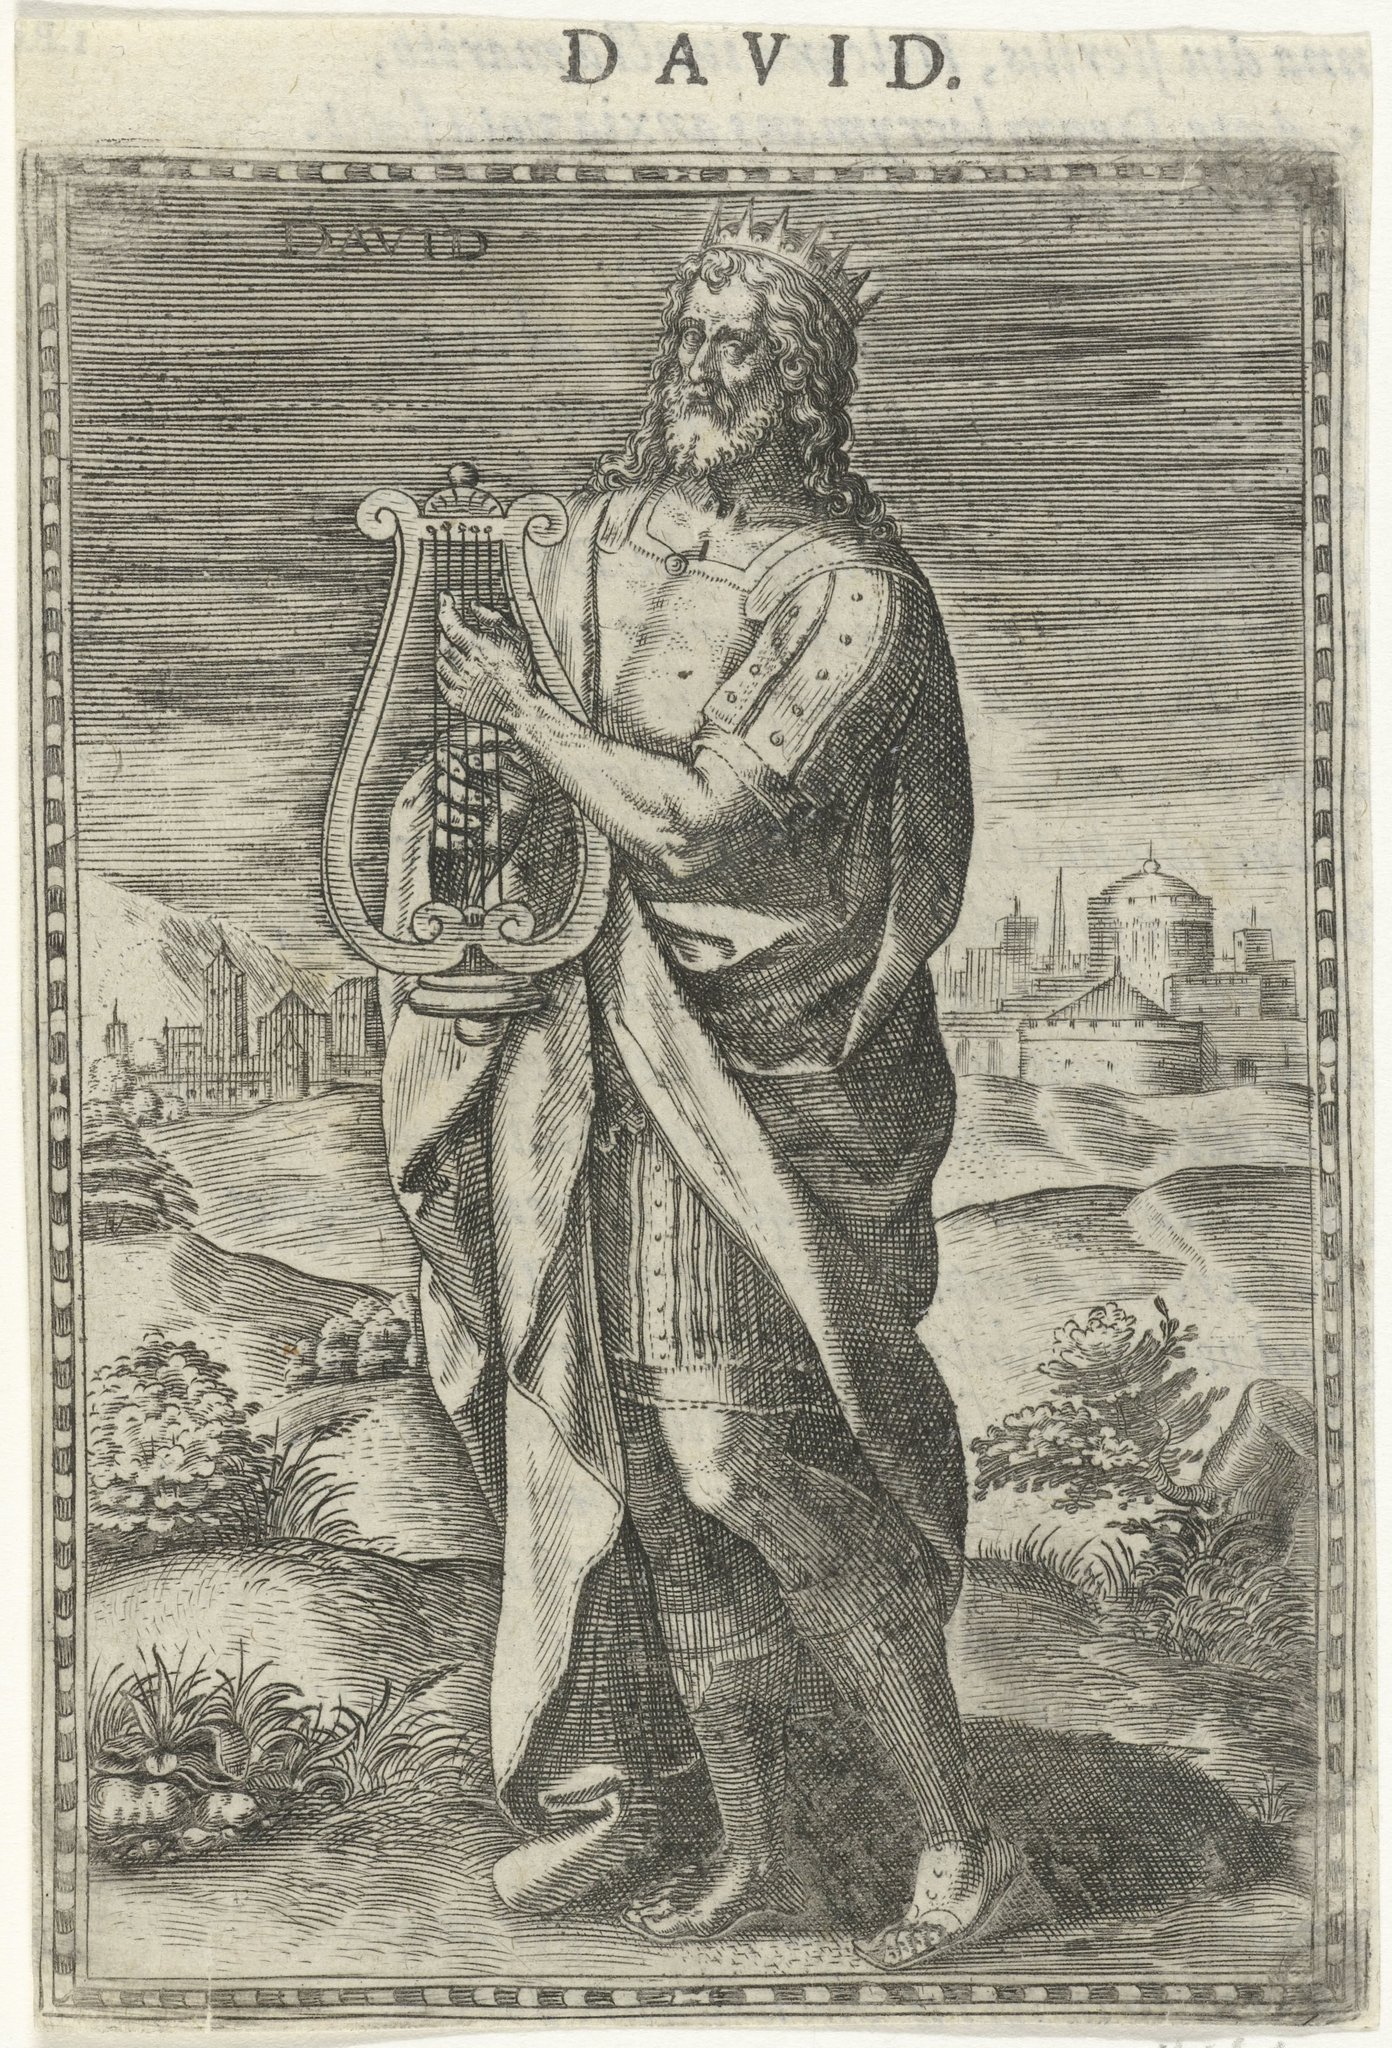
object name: print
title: Koning David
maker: johann sadeler (i)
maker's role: print maker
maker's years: 1550-1600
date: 1577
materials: paper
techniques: engraving, letterpress printing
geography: antwerp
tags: david (not in biblical context); possible attributes: crown, harp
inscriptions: collector's mark: Lugt 240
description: Boekillustratie voor Hillesem, Louis. Sacrarum antiquitatum monumenta. Antwerpen: Christoffel Plantin, 1577.